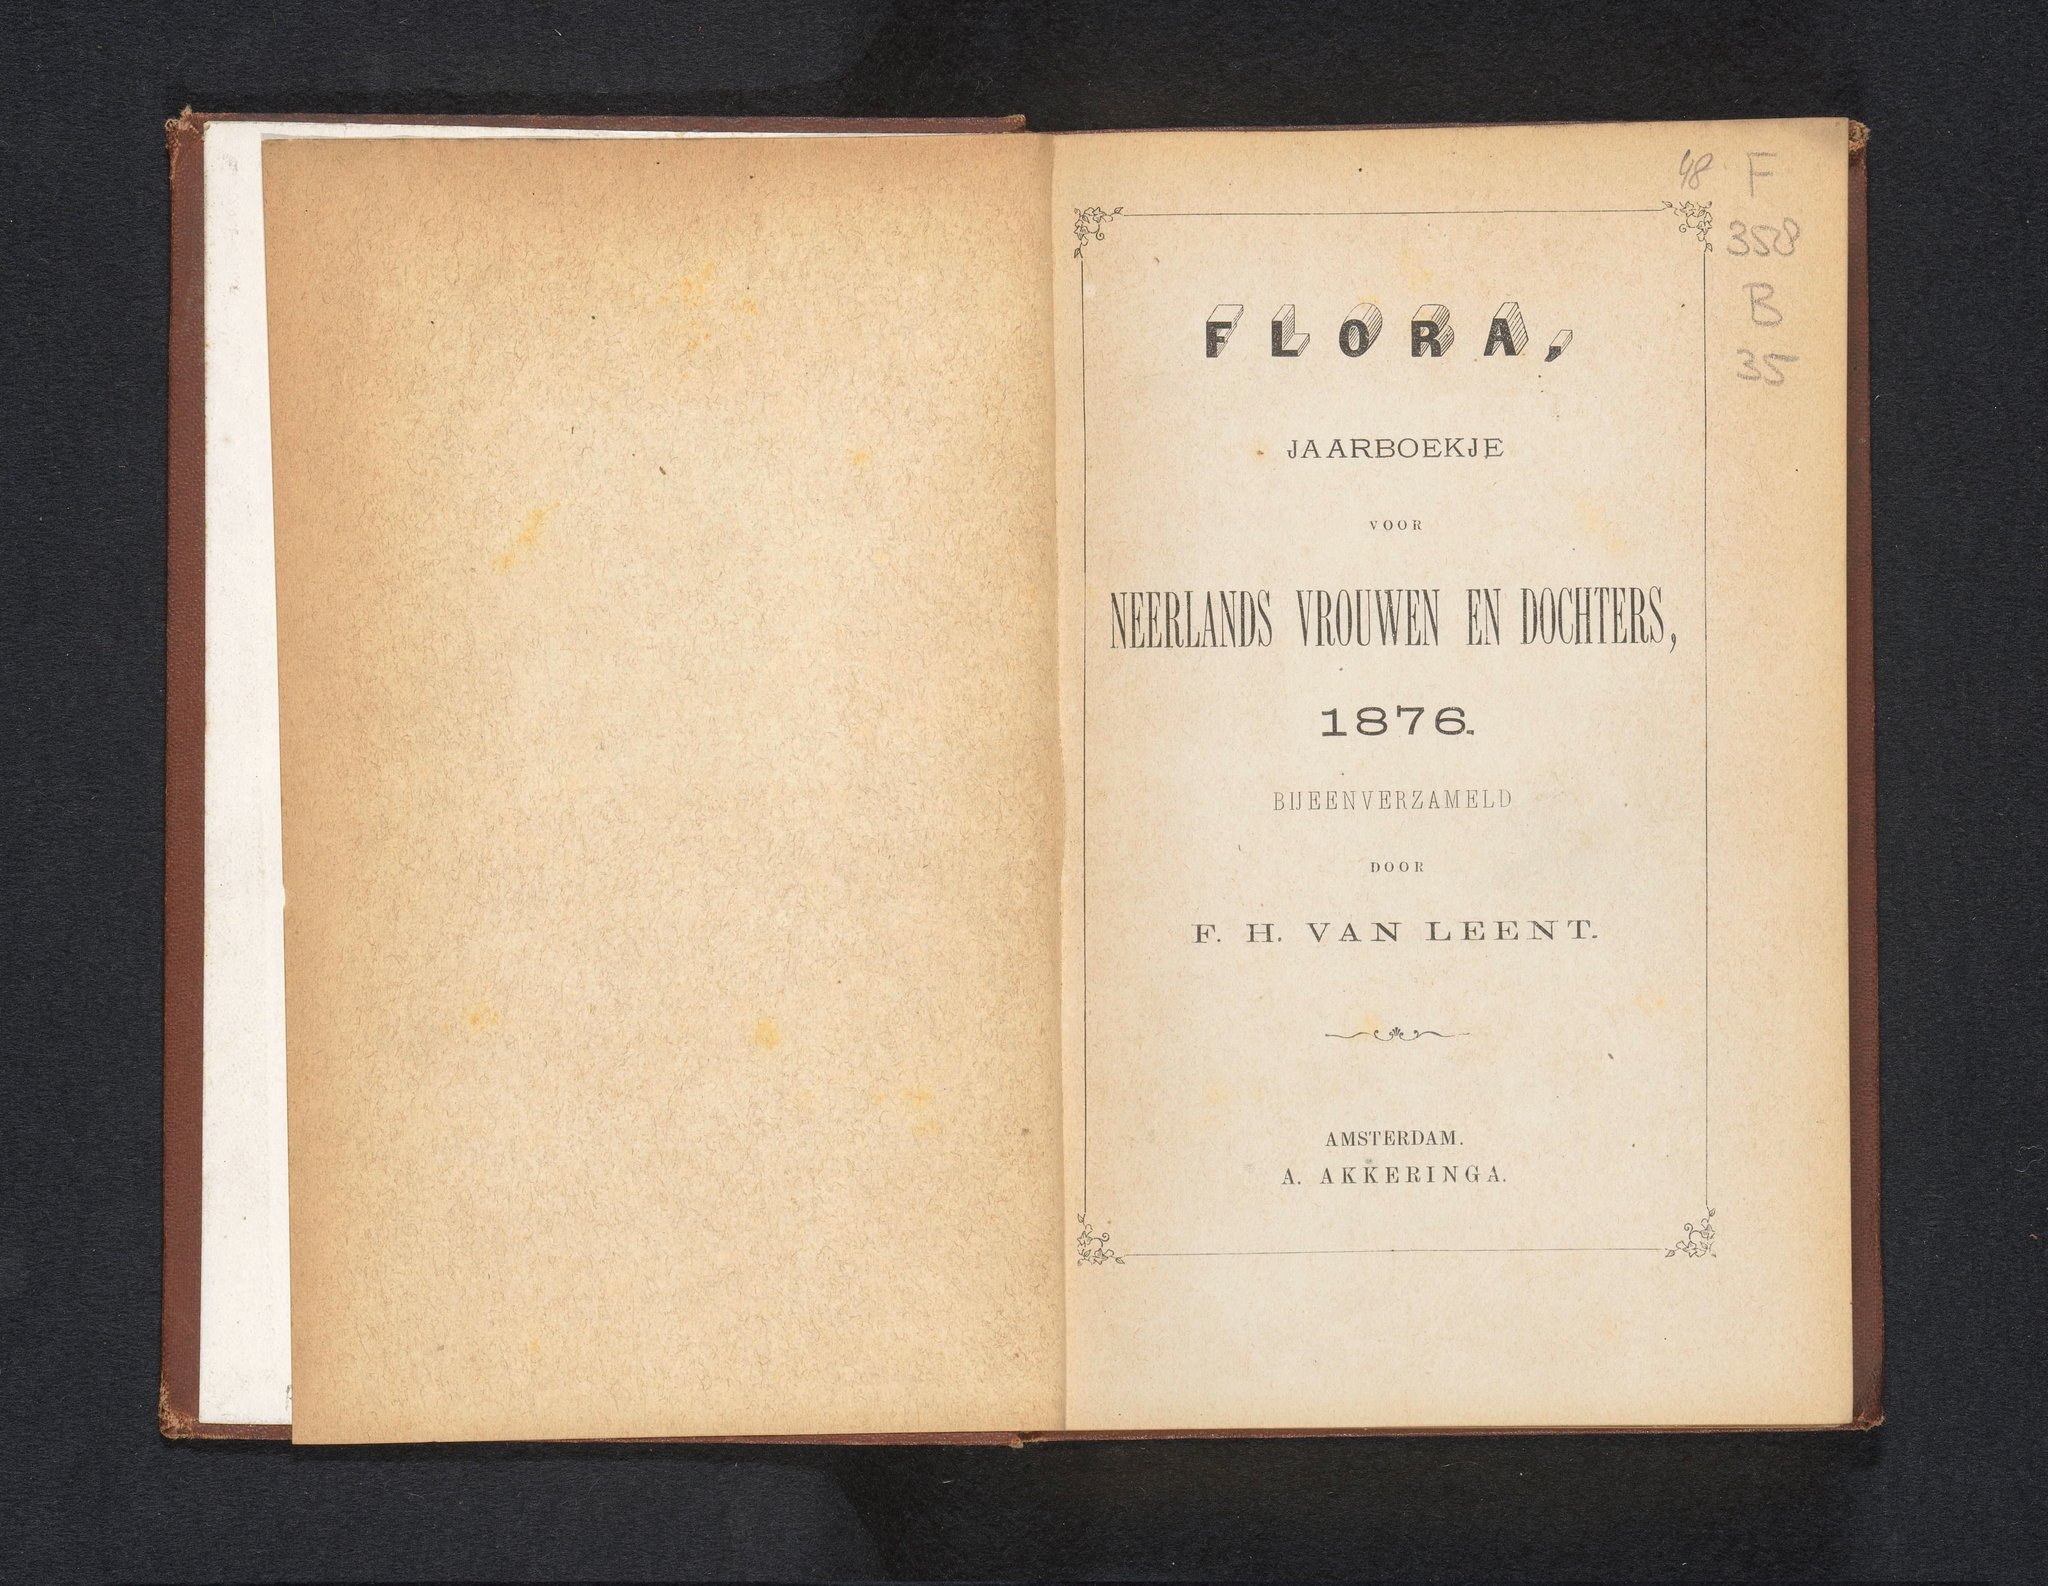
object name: book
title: Flora: jaarboekje voor Neerlands vrouwen en dochters/ bijeenverz. door F.H. van Leent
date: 1876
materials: cardboard, linen, paper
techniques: albumen print, printing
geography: amsterdam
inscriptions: bookplate: ‘EX/ BIBLIOTHECA/J.F.J. HEREMANS’, annotation: ‘FEB/ 2006’